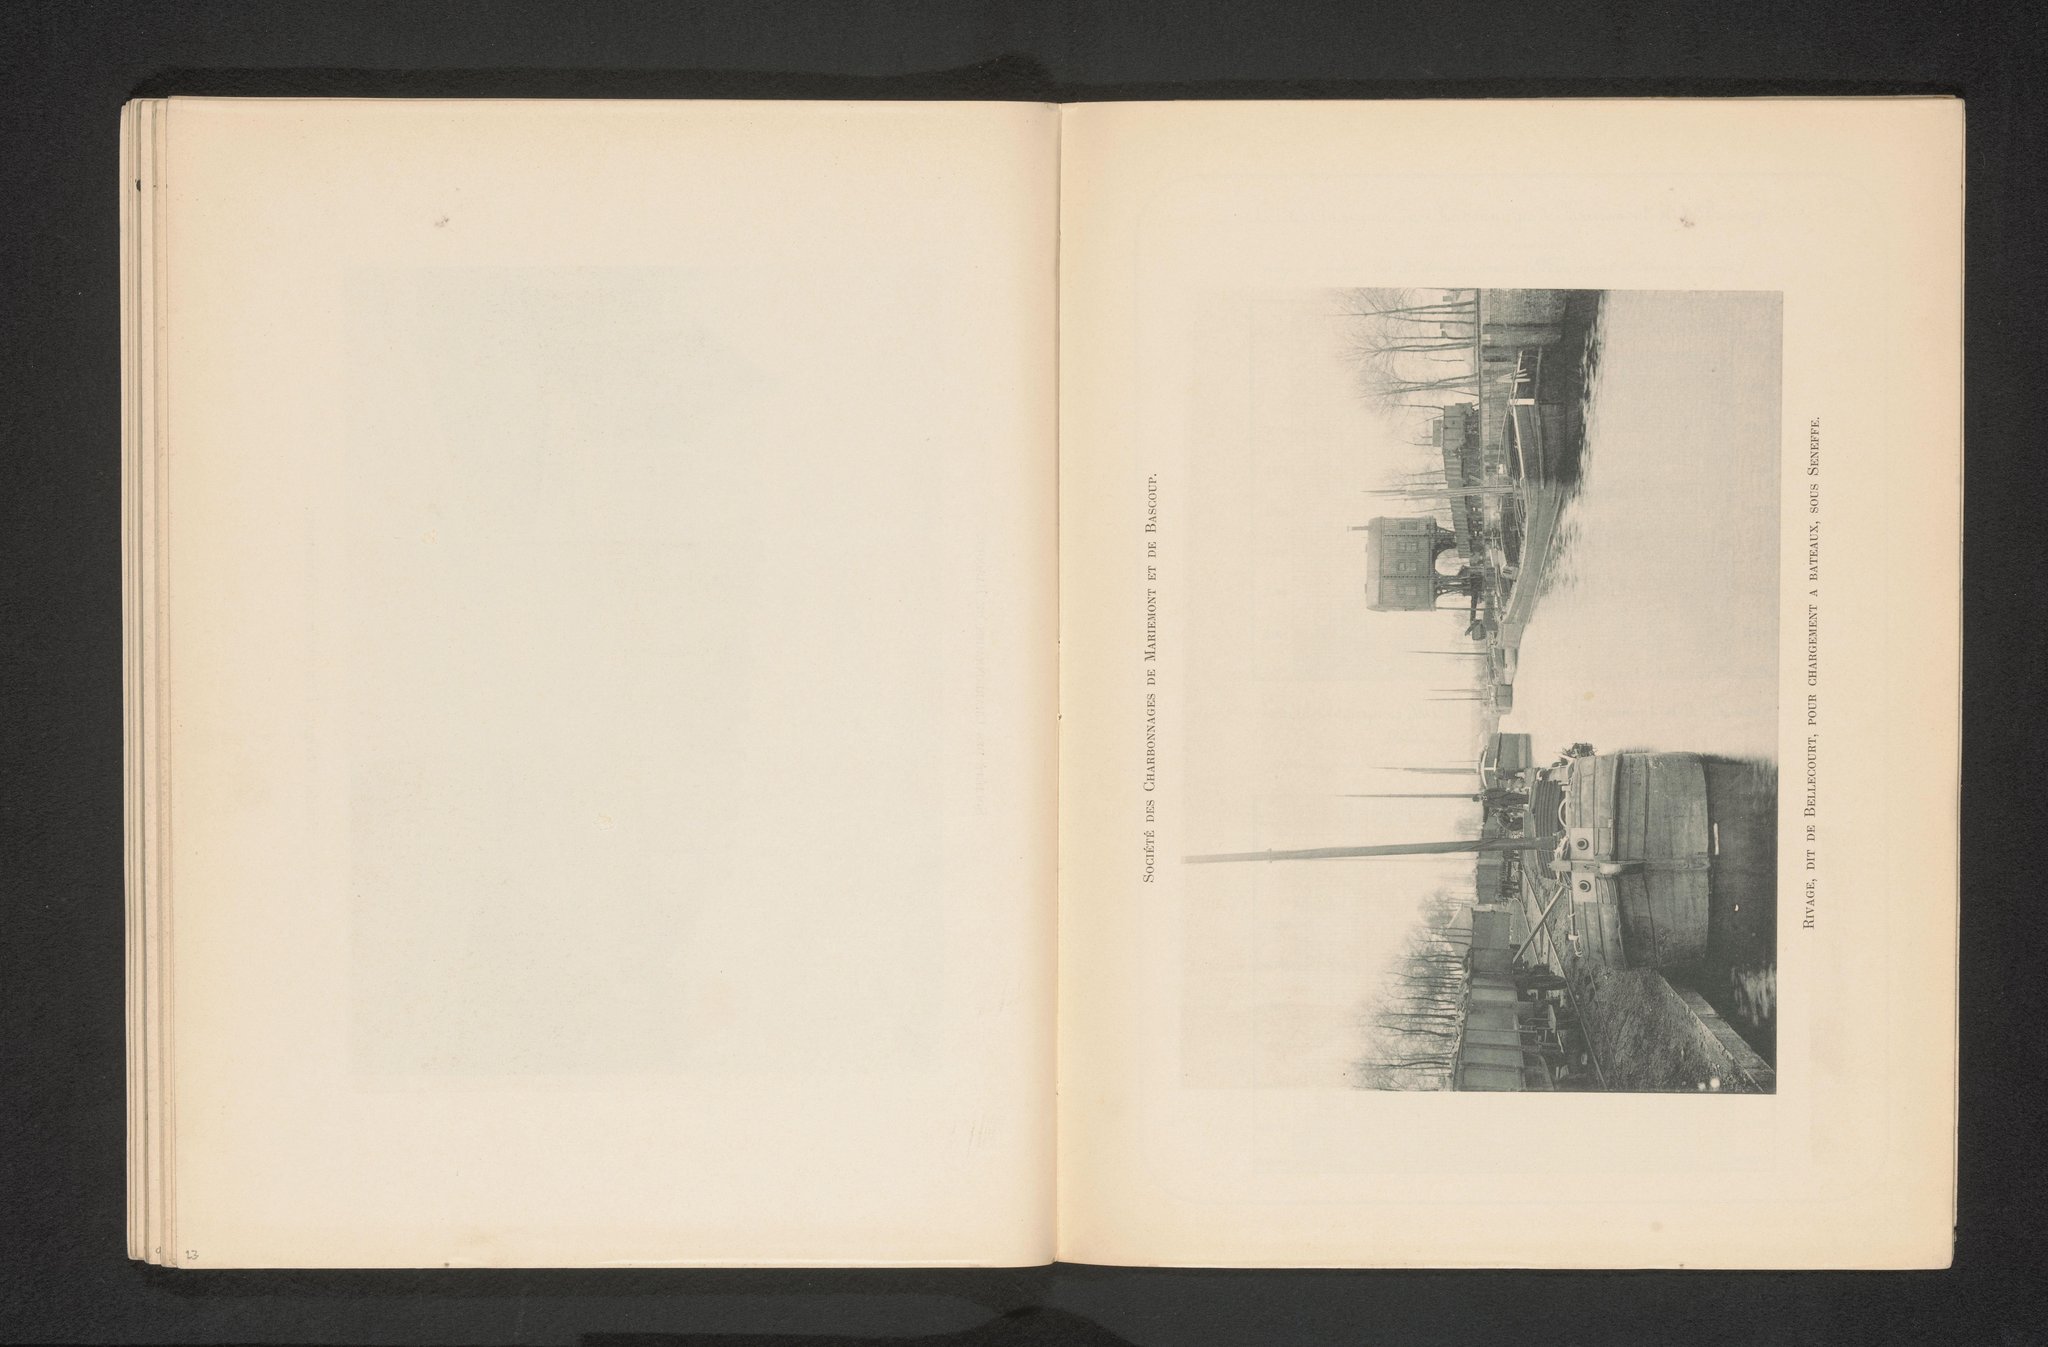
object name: page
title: Kanaal met vrachtschepen voor kolen te Seneffe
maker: Anonymous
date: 1895-1900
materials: paper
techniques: photograph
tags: freight vessel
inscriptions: inscription: ‘Société des Charbonnages de Mariemont’